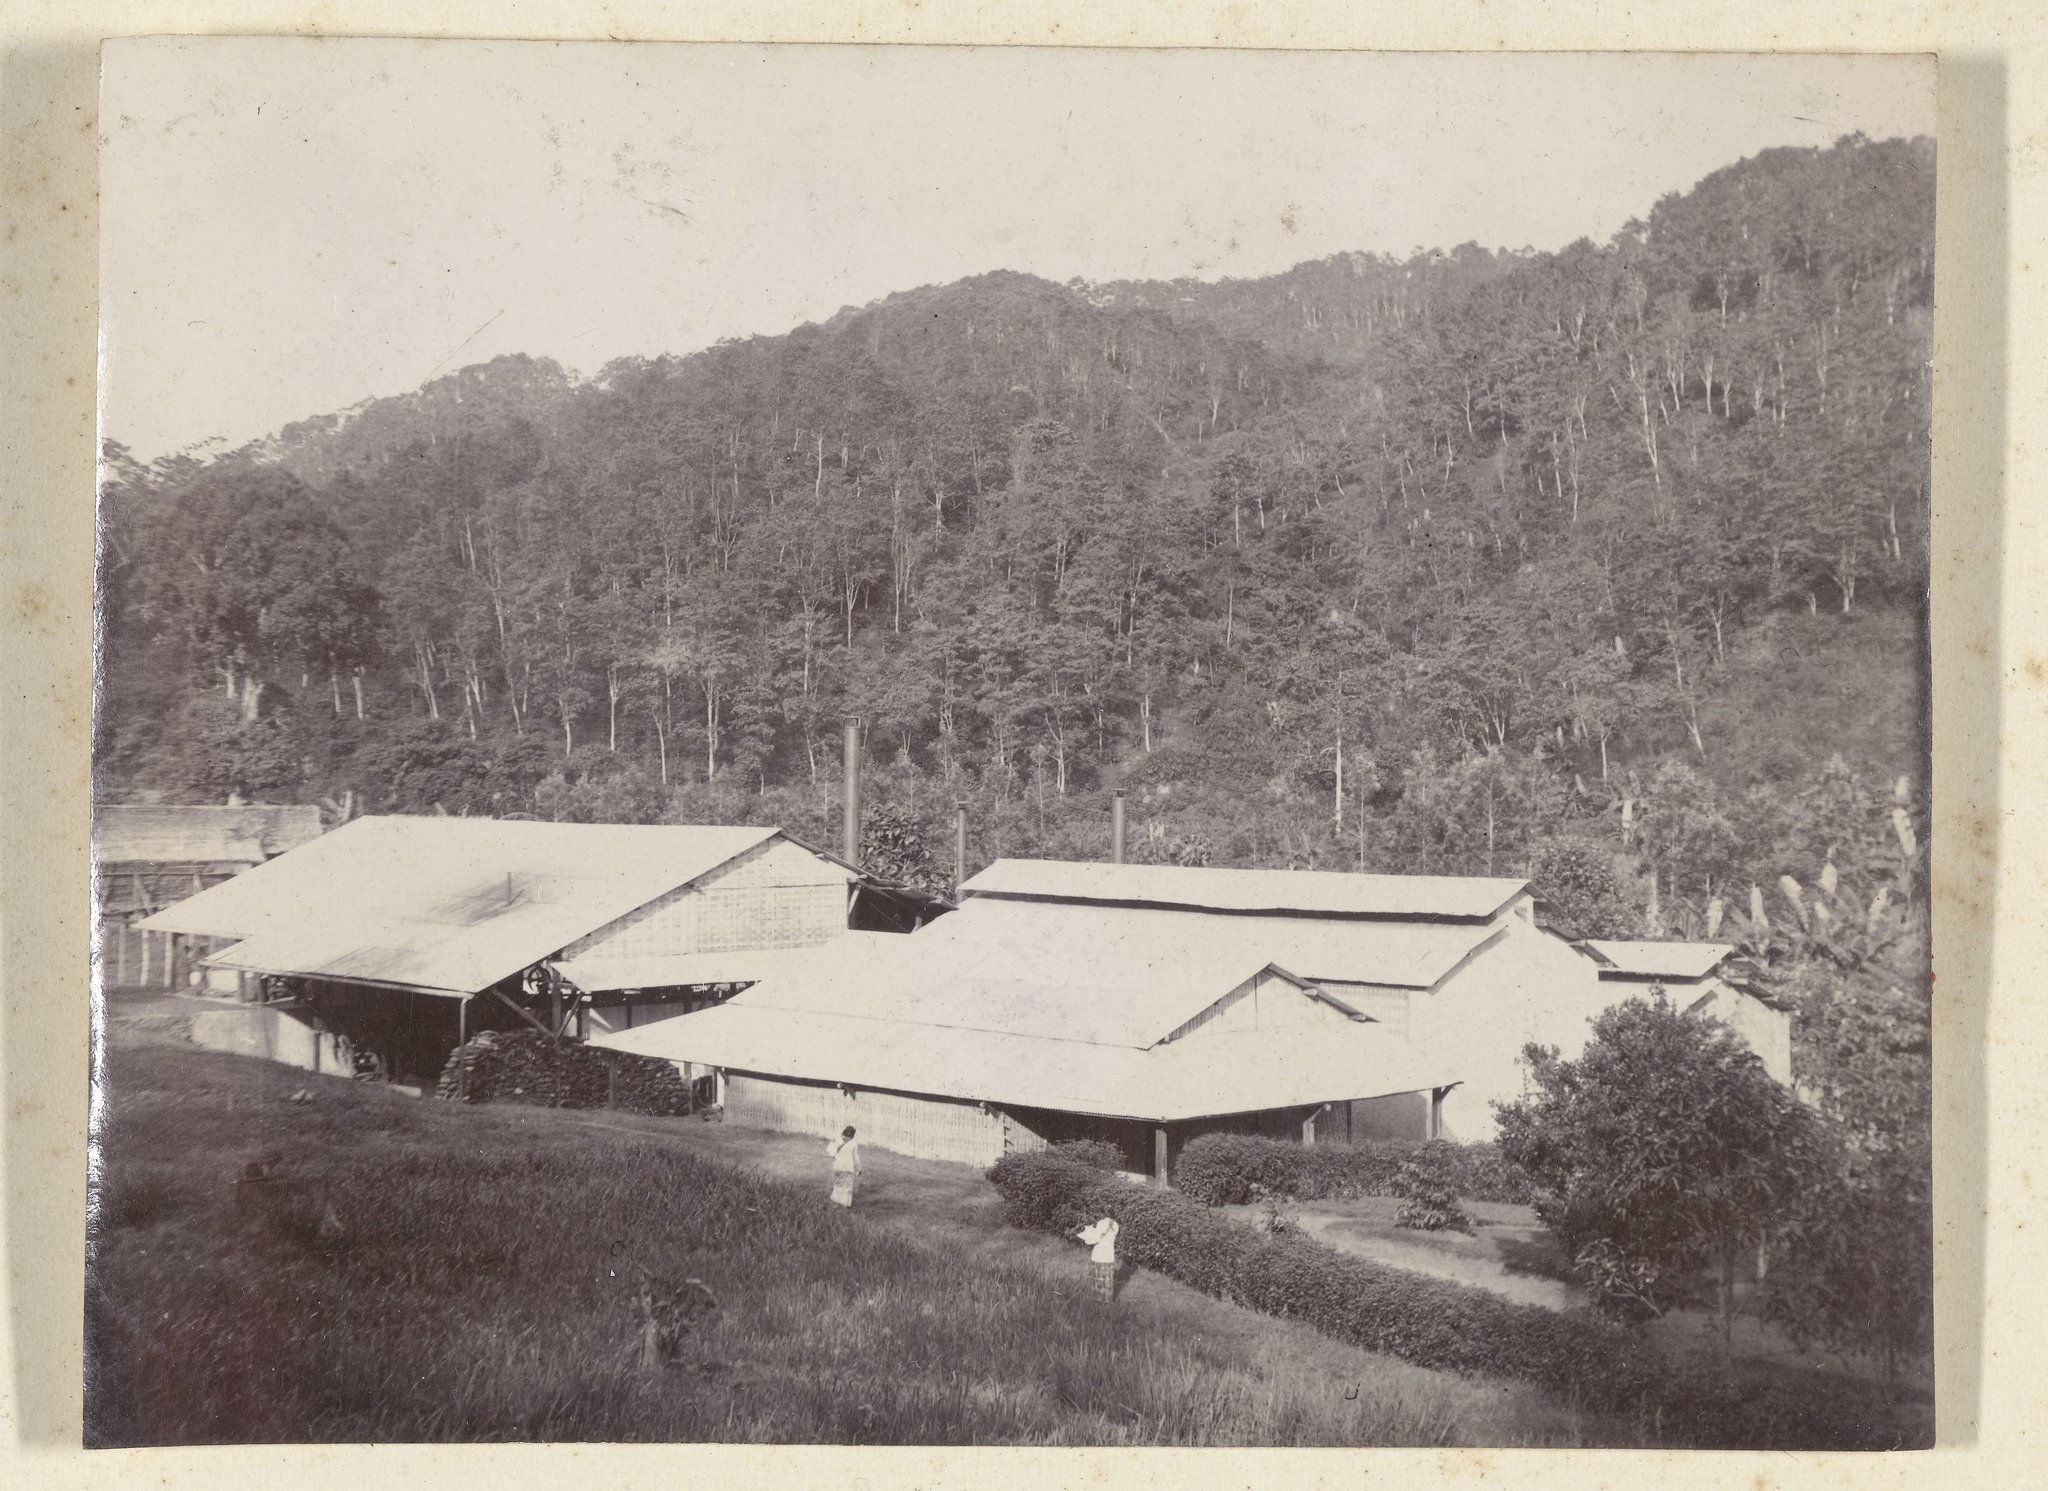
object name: photograph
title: Gebouwen behorende bij plantage Silo Sanen gezien vanaf een hoger gelegen gedeelte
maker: Anonymous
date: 1890-1910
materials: cardboard, paper, photographic support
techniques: gelatin silver print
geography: netherlands